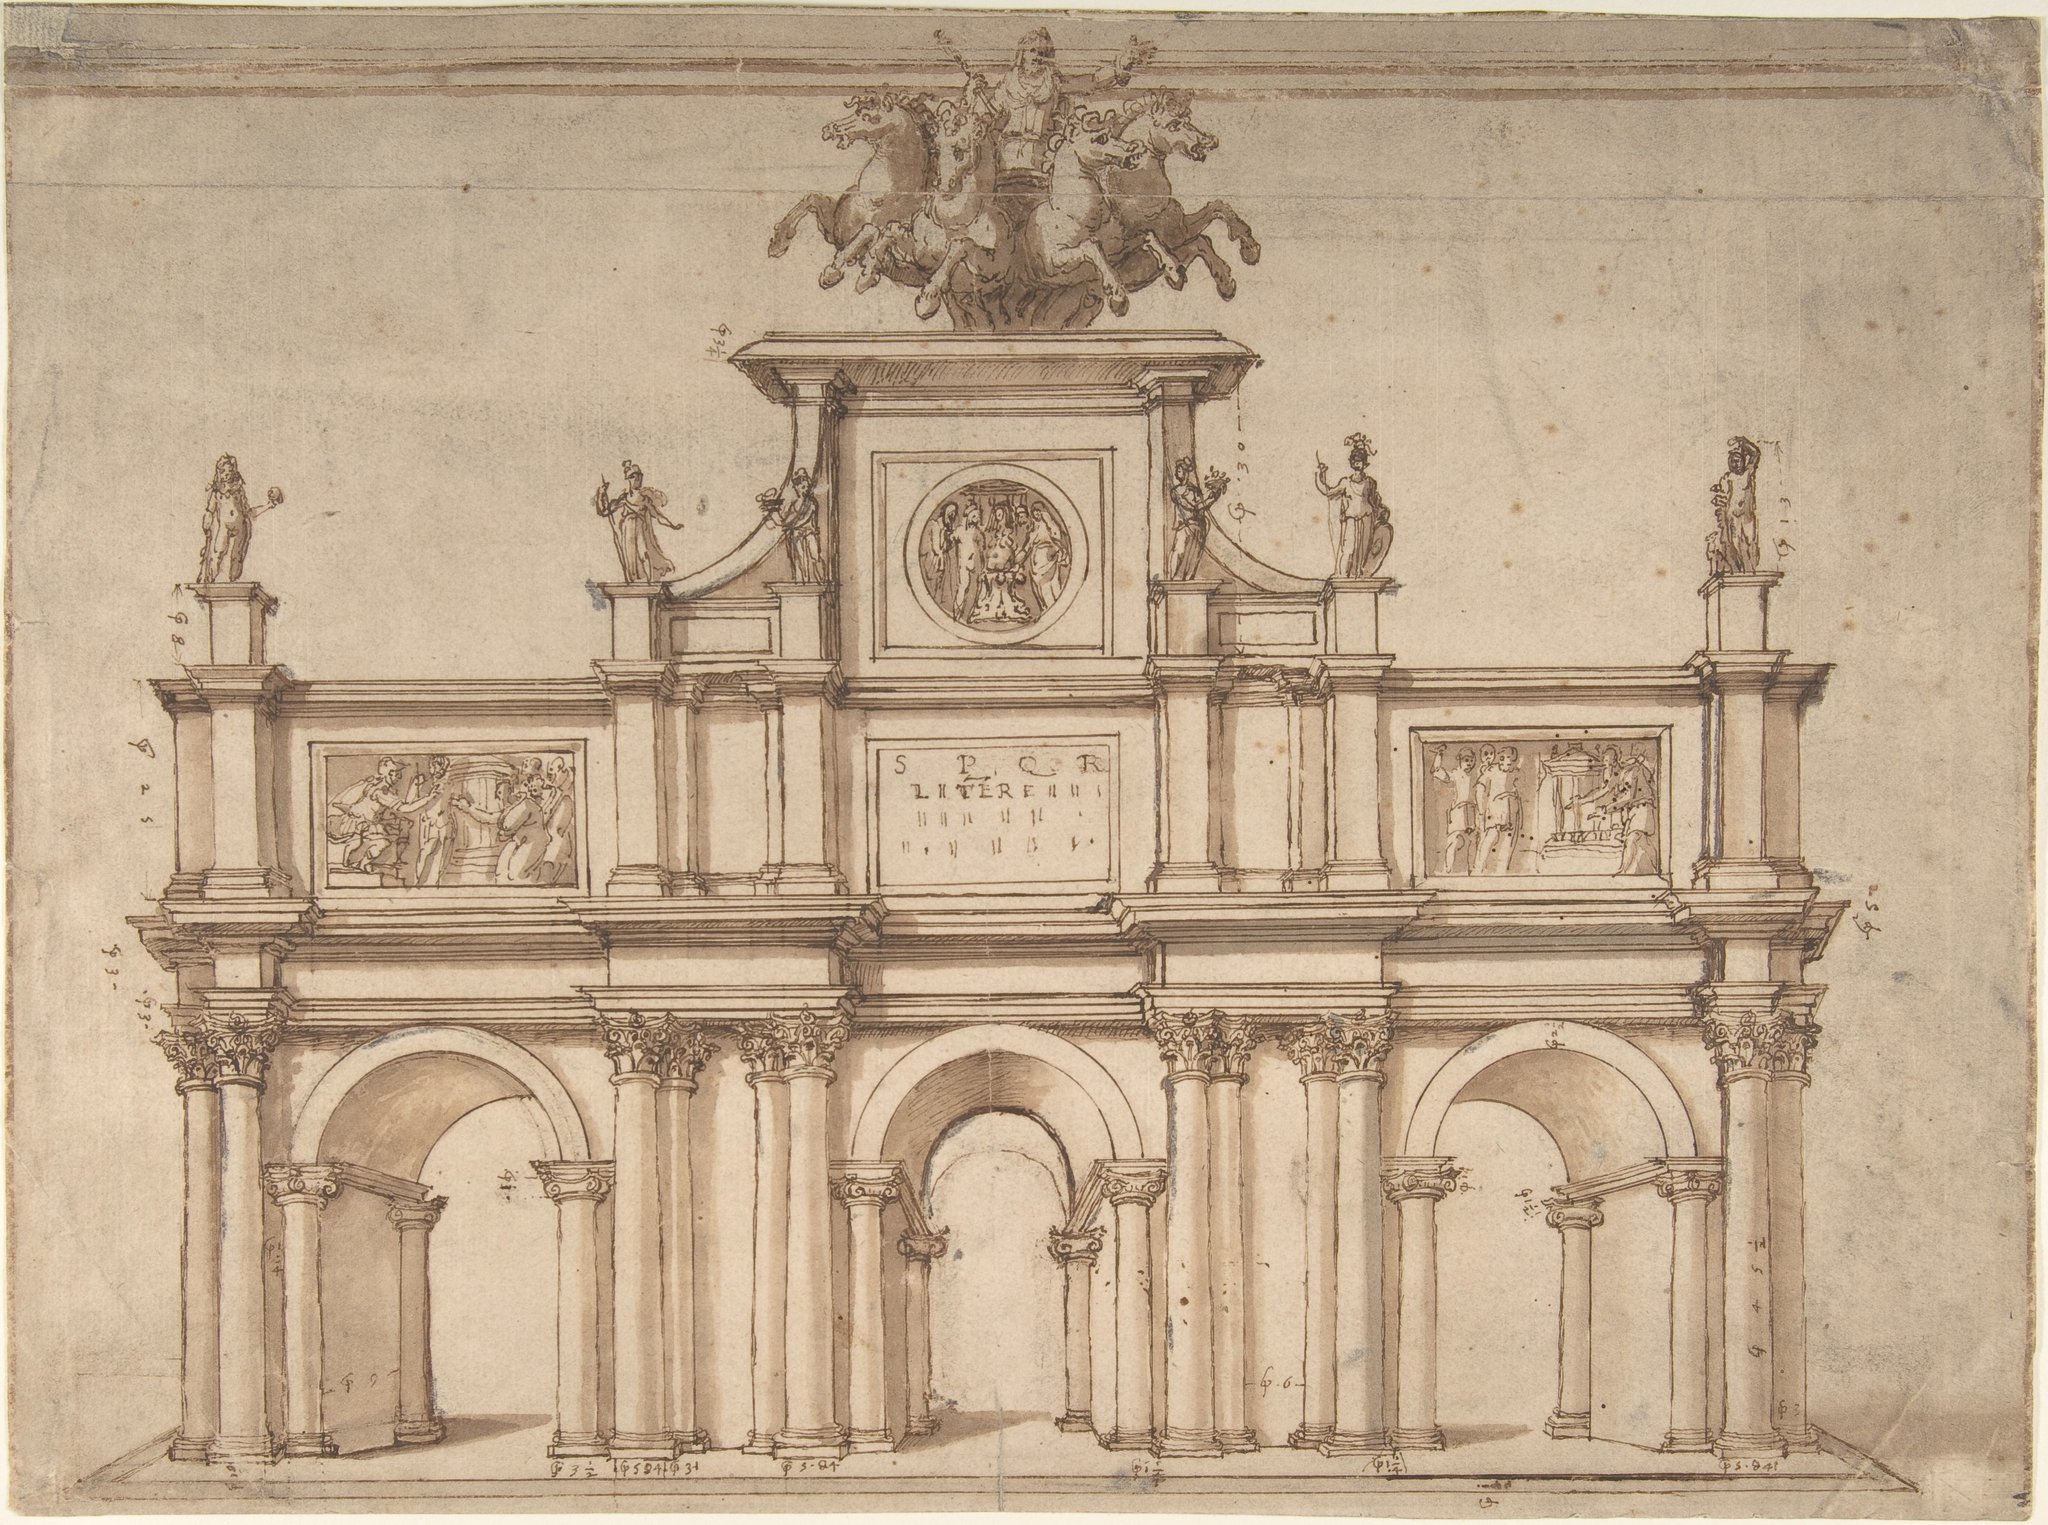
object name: drawing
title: Design for a Triumphal Arch with Three Arches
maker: anonymous, italian, 16th century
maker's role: artist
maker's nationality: italian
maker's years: 1500-1600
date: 1501-1600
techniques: brush, pen, wash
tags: architecture,arches,horses